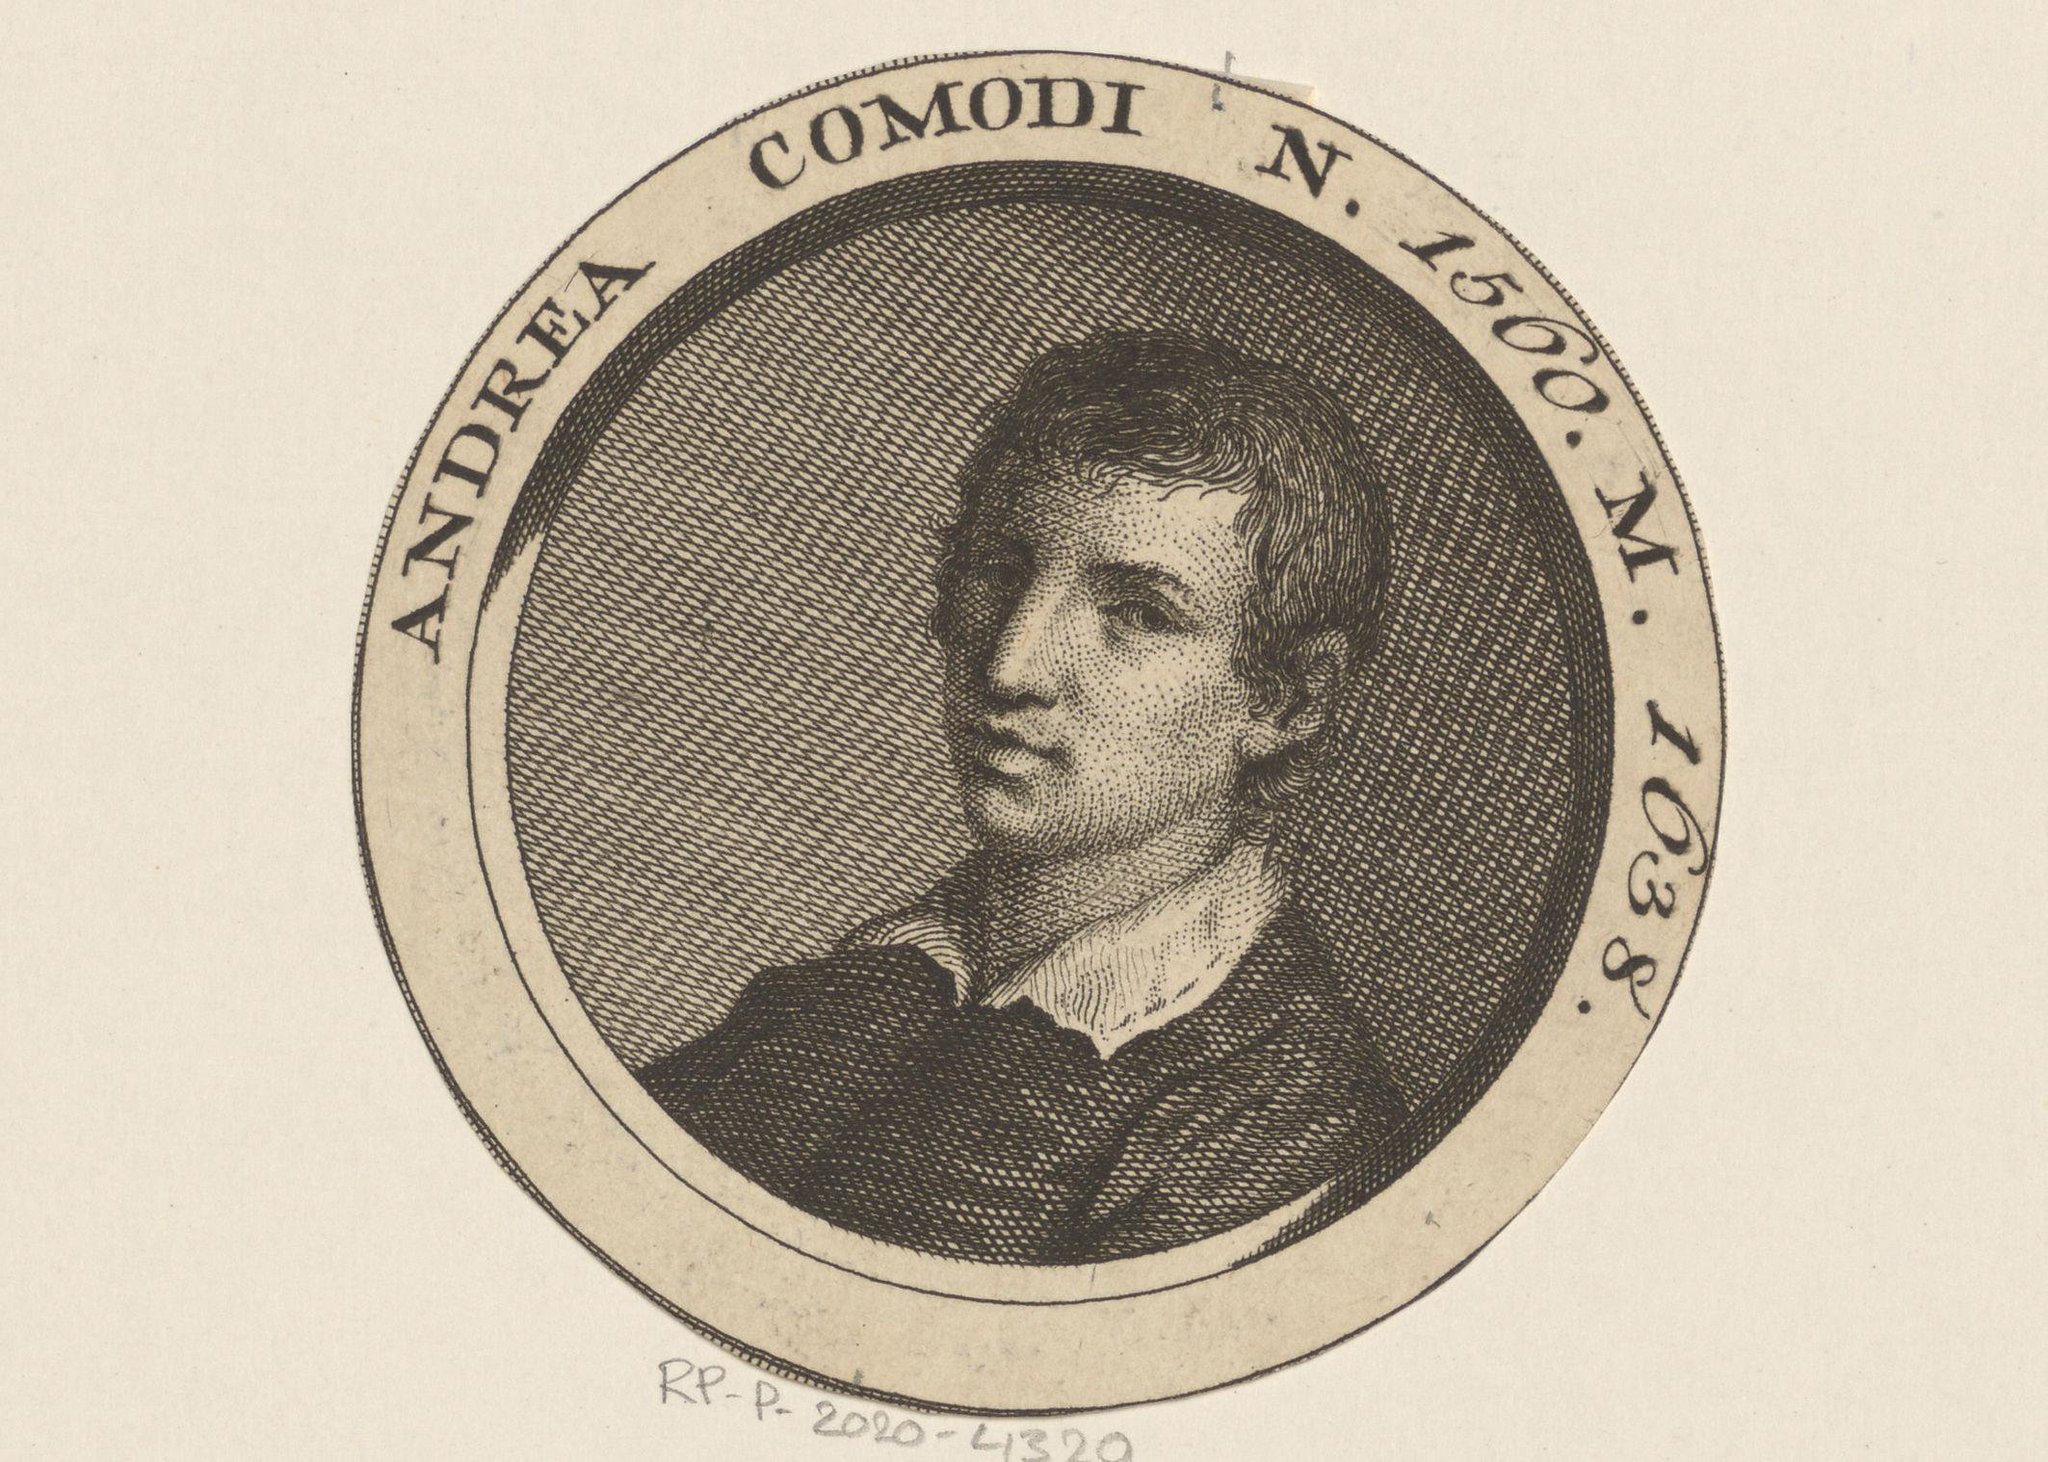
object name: print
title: Portret van Andrea Commodi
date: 1795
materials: paper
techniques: etching, letterpress printing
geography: florence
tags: draughtsman, andrea commodi, historical persons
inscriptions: collector's mark: Lugt 2228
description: Prent uit: L'Etruria pittrice ovvero storia della pittura Toscana (...). Florence: Niccolo Pagni en Giuseppe Bardi, 1795, dl. 2.